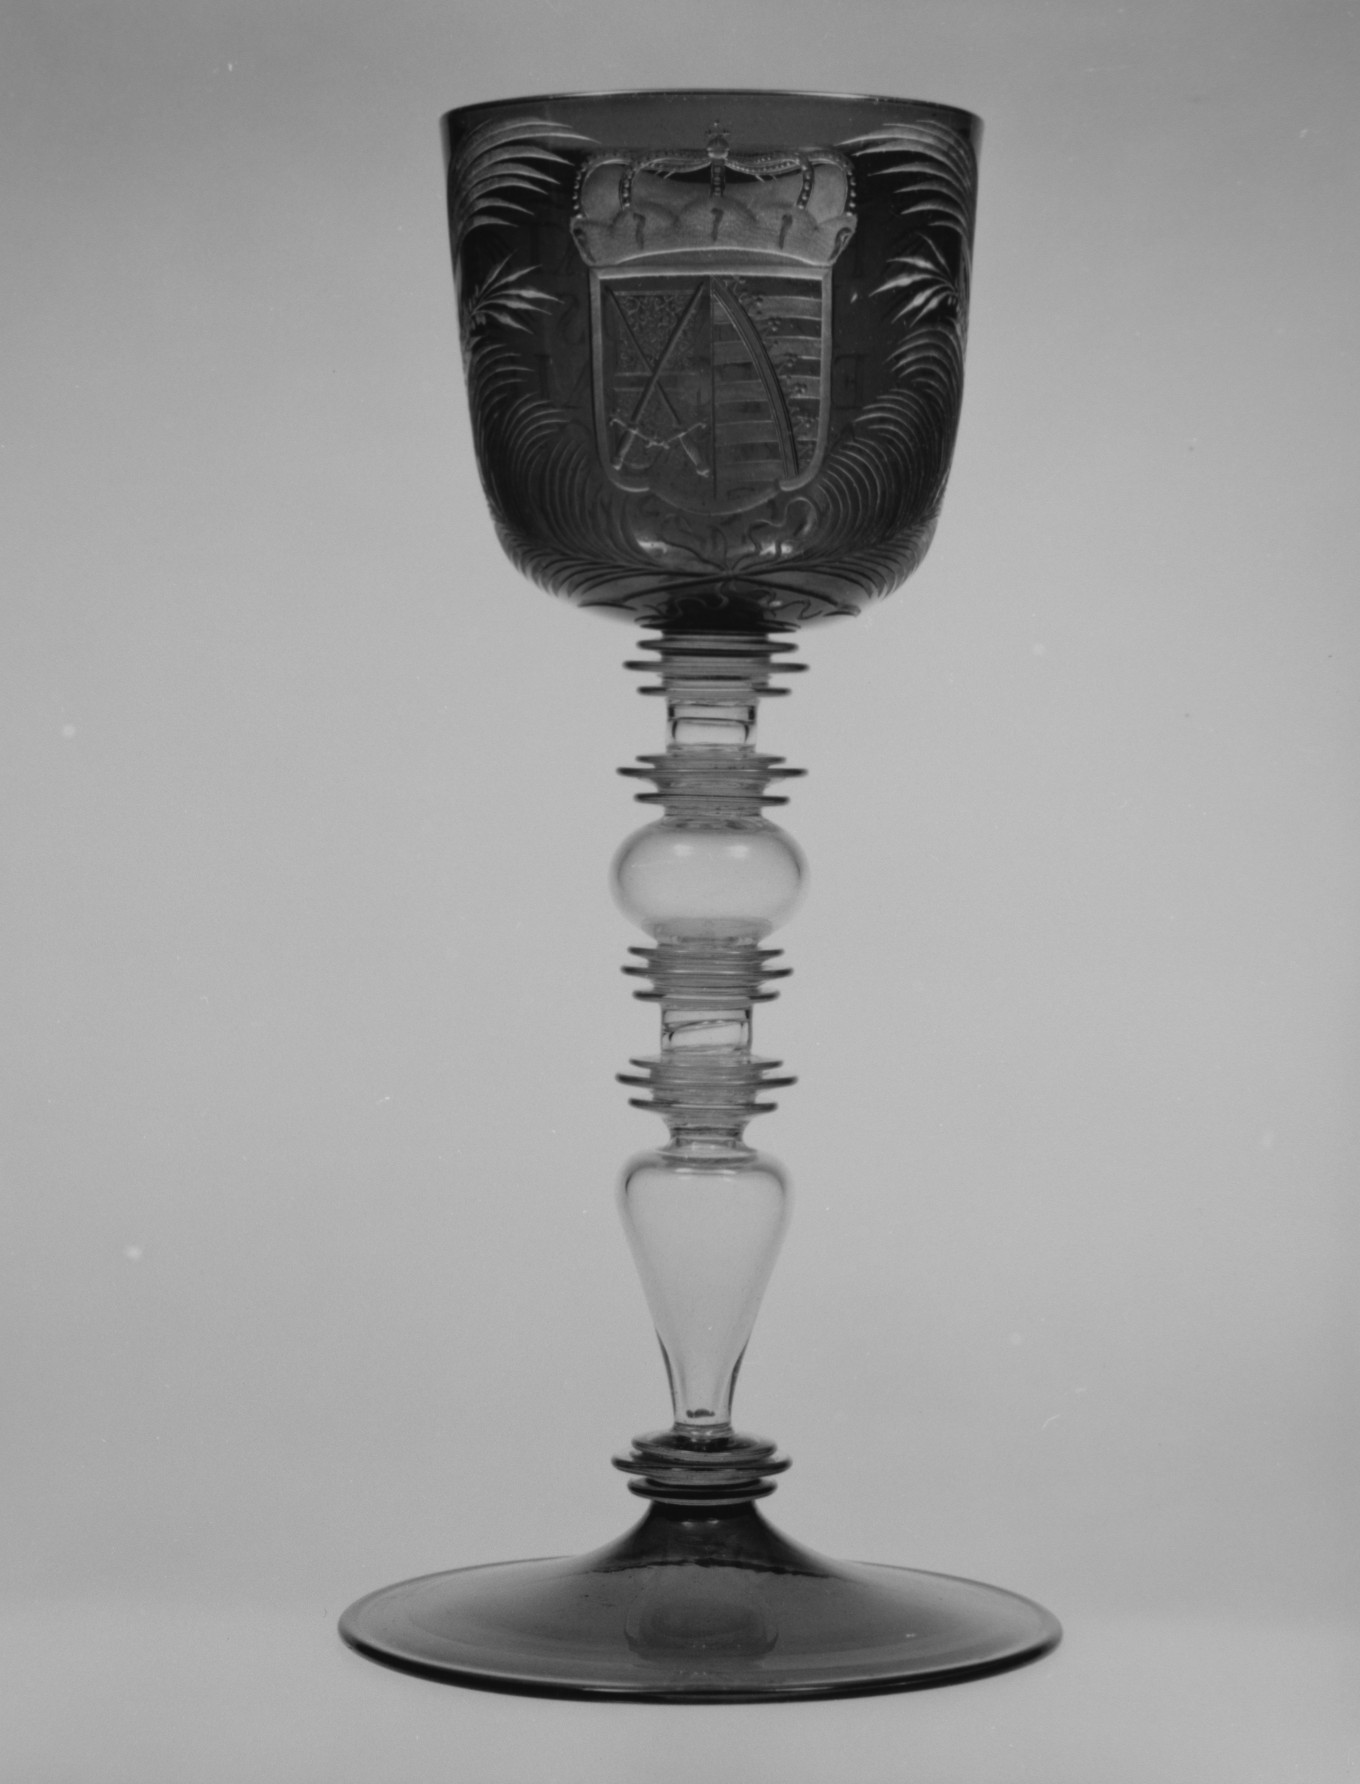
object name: goblet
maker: hermann schwinger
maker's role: maker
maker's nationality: german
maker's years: 1640-1683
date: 1670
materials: glass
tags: coat of arms